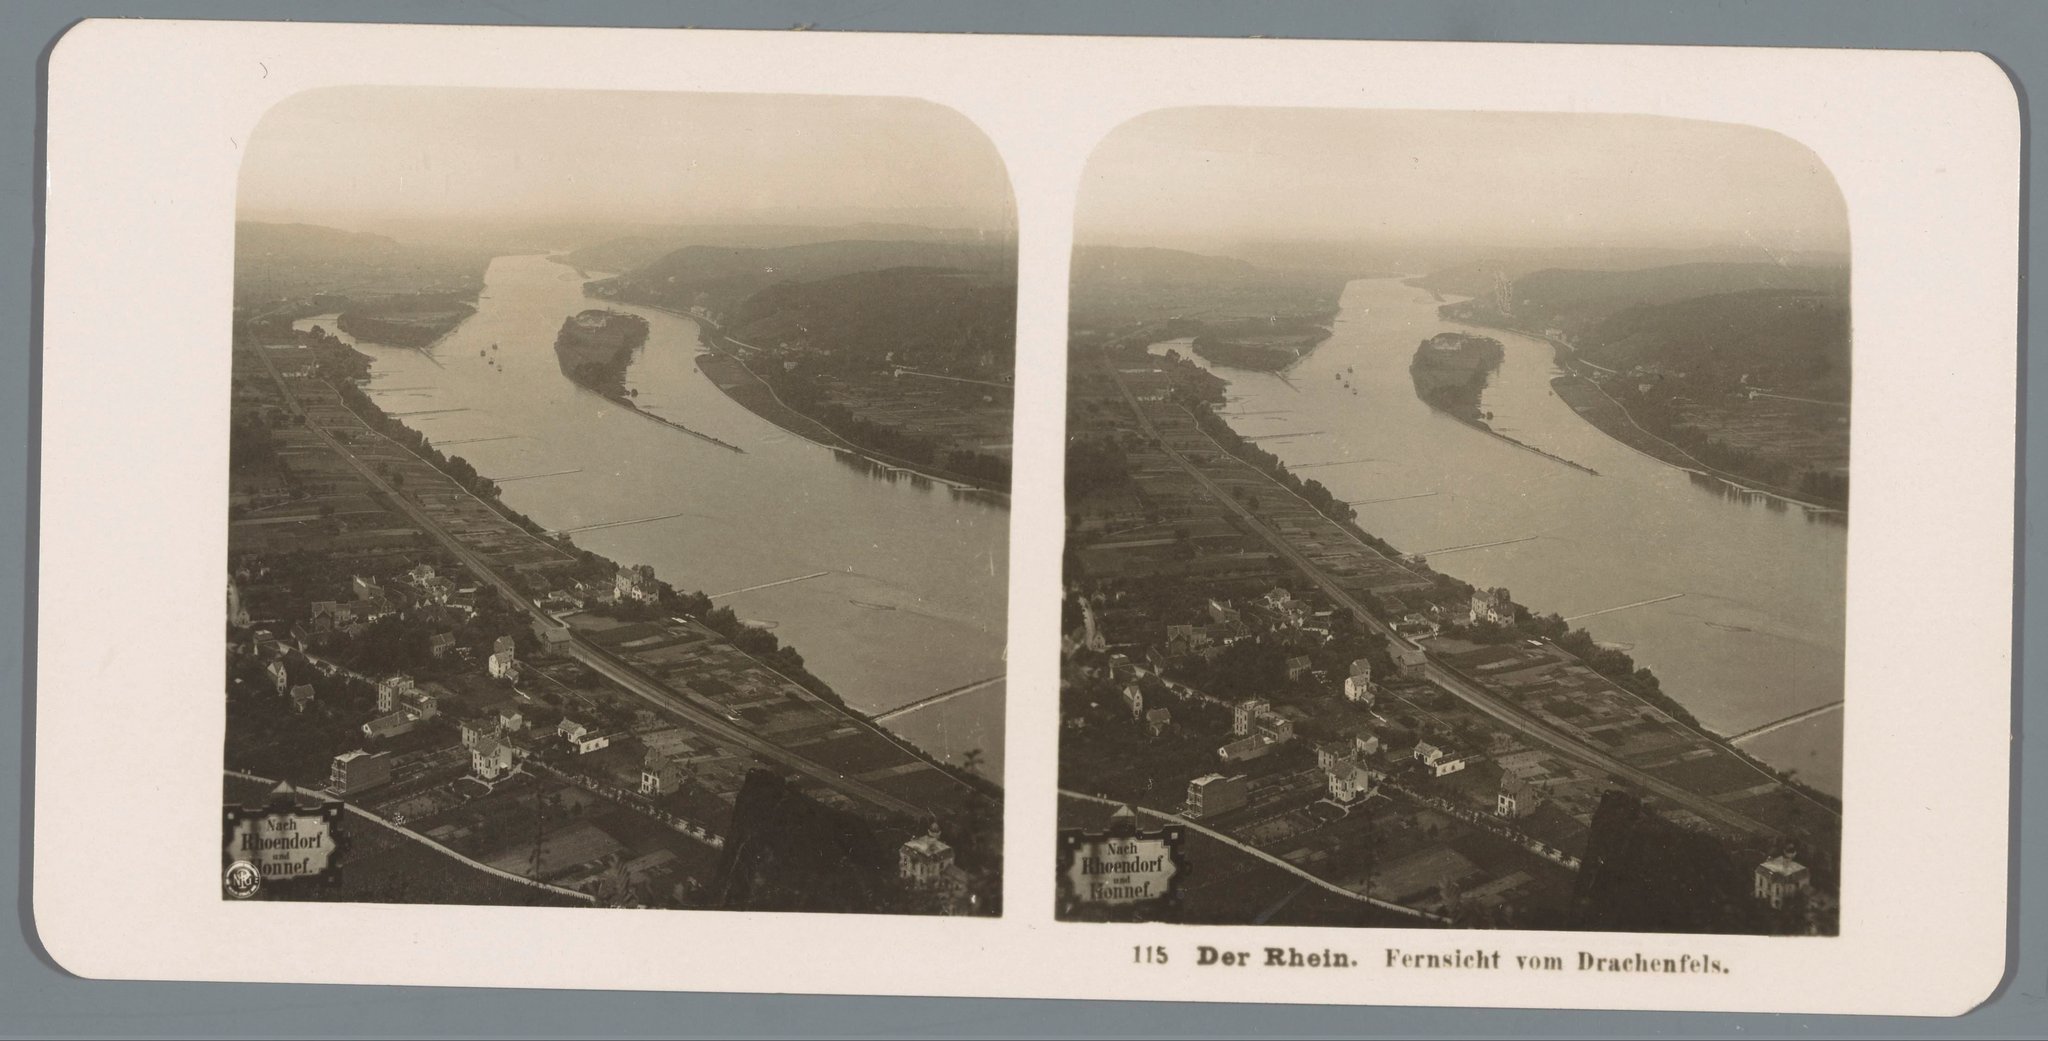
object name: stereograph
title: Der Rhein. Fernsicht vom Drachenfels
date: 1900-1910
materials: cardboard, photographic support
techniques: gelatin silver print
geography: drachenfels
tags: city-view in general; 'veduta', river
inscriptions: number: ‘115’, inscription: ‘NPG’